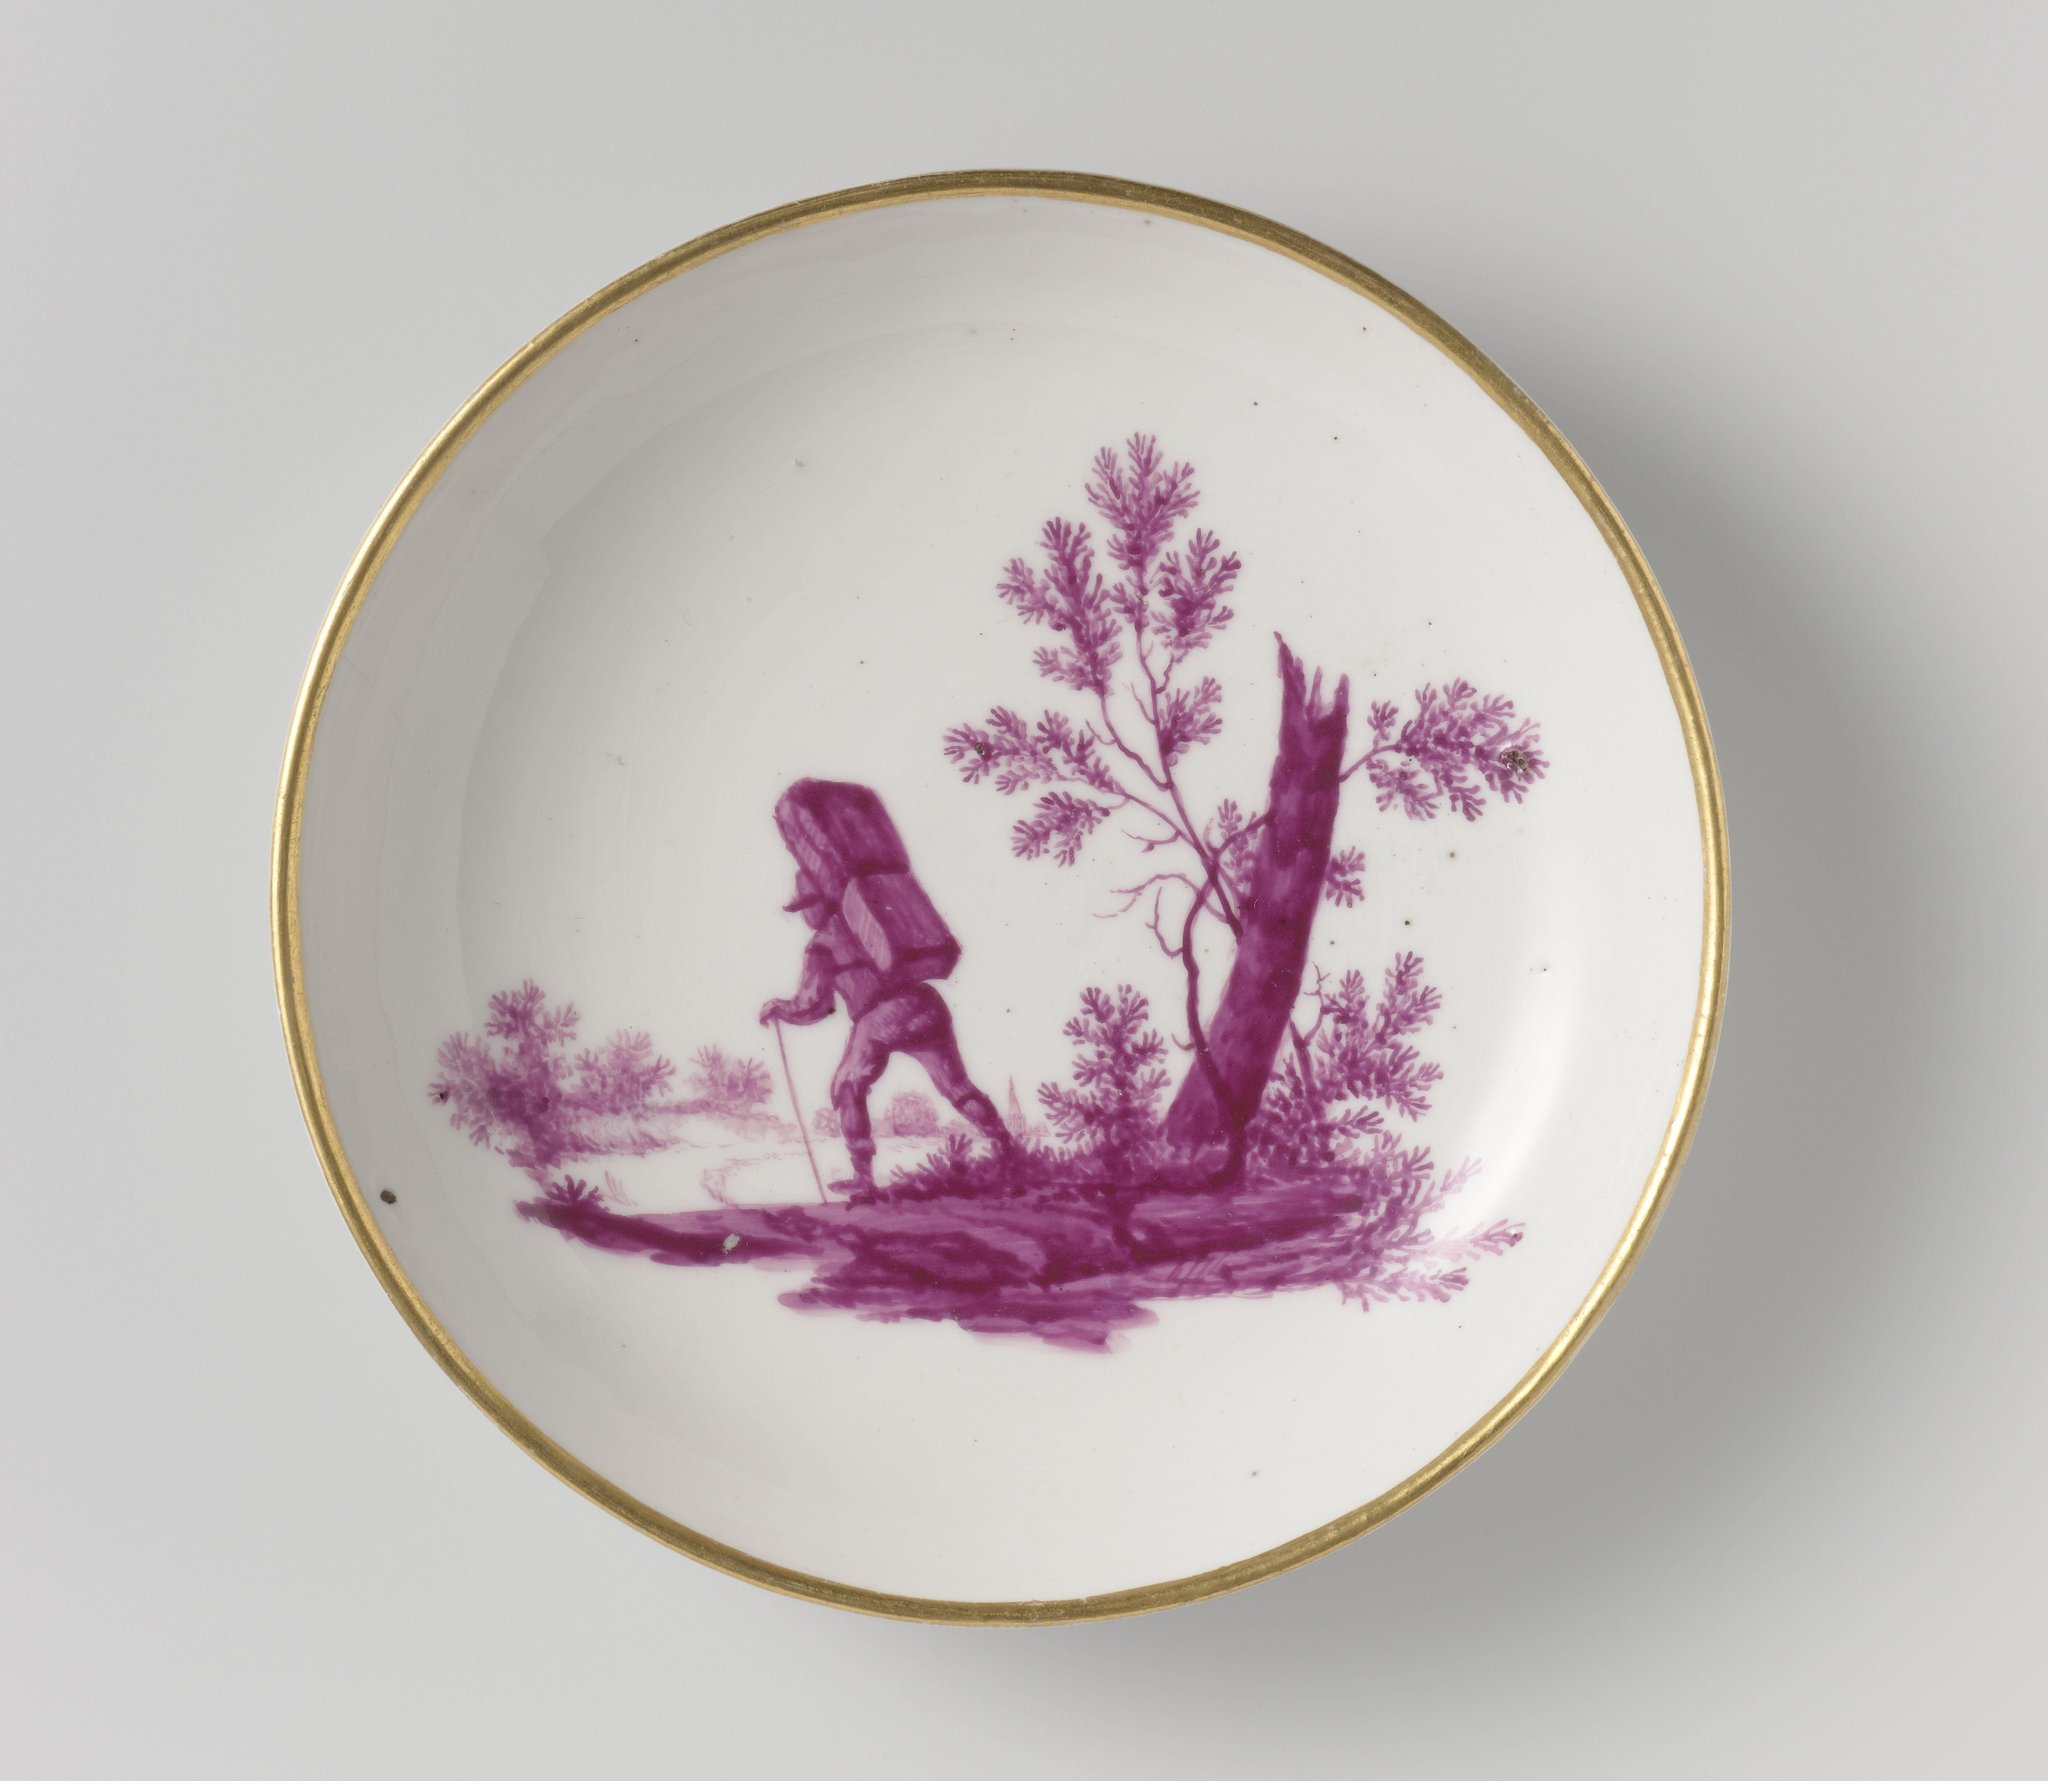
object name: platter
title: Schotel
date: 1775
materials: porcelain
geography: loosdrecht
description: Schotel van porselein. Onderdeel van een serie van twaafl stuks. Beschilderd met figuren in een landschap in bietenrood en gouden biezen.